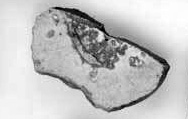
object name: shard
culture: korean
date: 1401-1500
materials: pottery